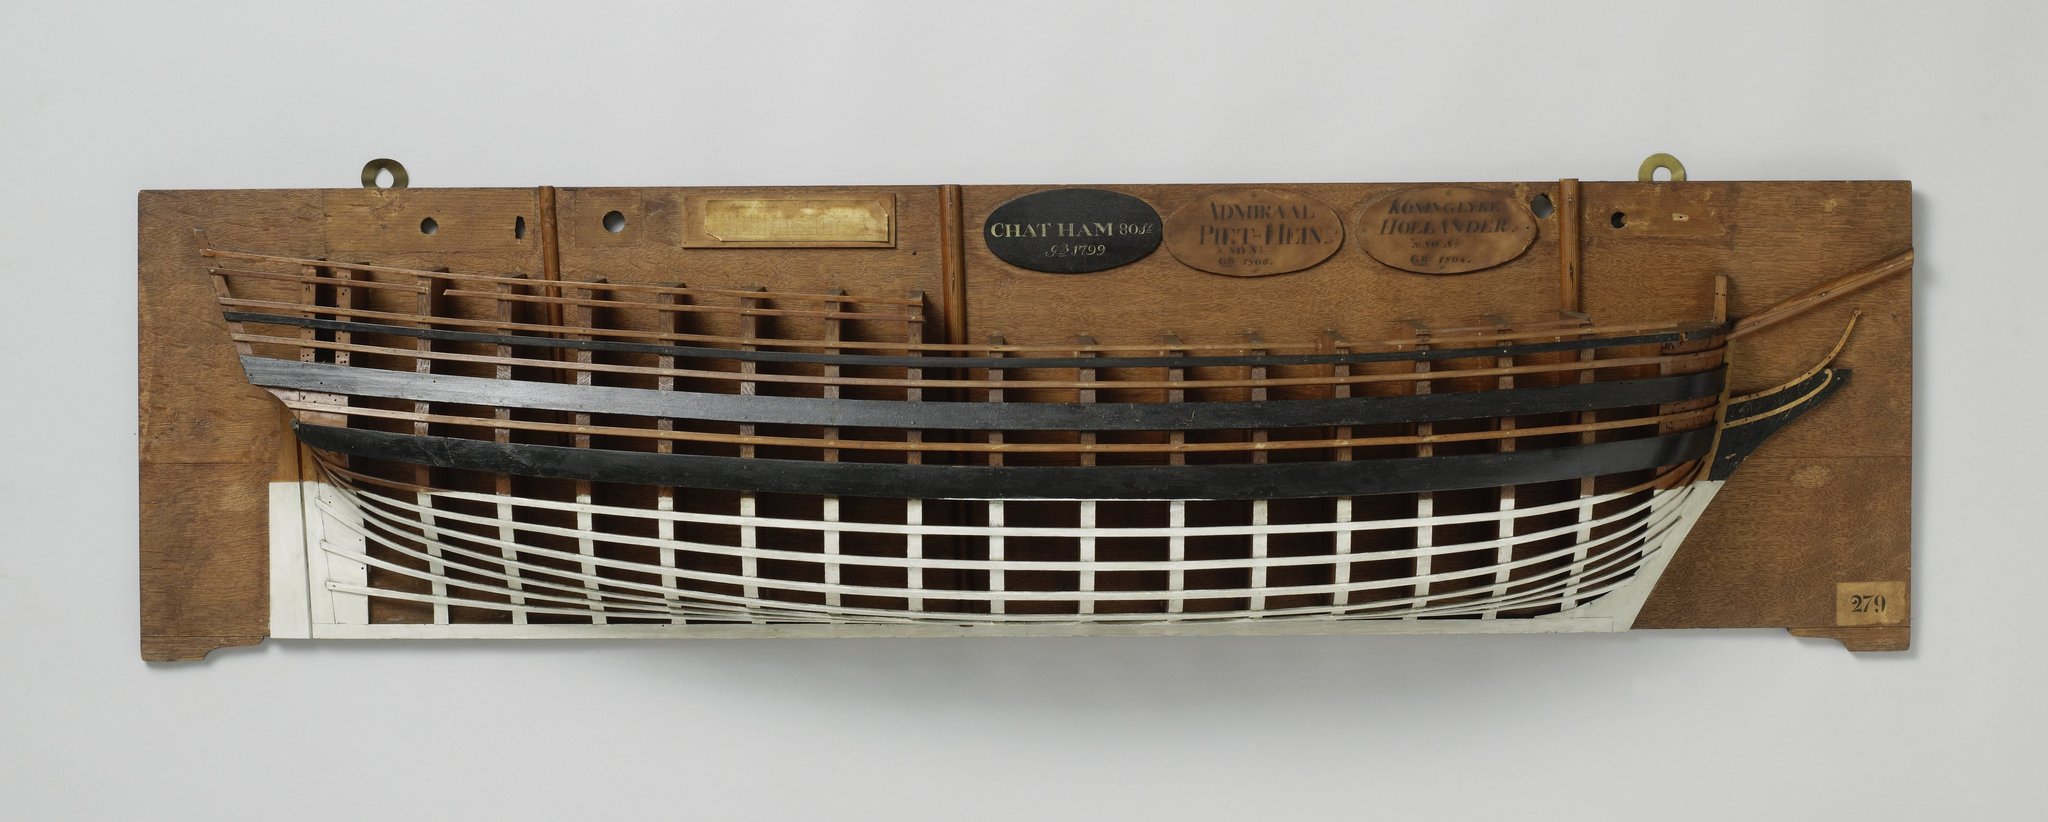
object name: half model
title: Half Model of a 74-Gun Ship of the Line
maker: Anonymous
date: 1806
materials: wood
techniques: polychromy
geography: netherlands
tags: admiraal piet hein (schip)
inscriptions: inscription, top, from left to right, on three oval paper labels (one painted black): ‘CHATHAM 80 St / GB 1799 // ADMIRAAL / PIET-HEIN / à 80 St / GB: 1806. // KONINGLYKE / HOLLANDER. / à 80 St / GB: 1804.’, label, bottom right: ‘279’ former inventory label, scale, top left: paper scale in Amsterdam feet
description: De opschriften zijn onbetrouwbaar. Volgens Obreen werd maar één schip volgens dit model gebouwd, de Admiraal Piet Hein van 195 voet, door P. Glavimans Jz. in Rotterdam in 1810-1813, gesloopt in 1819. Er is echter wel een 74-er Admiraal Piet Hein in Rotterdam op stapel gezet in 1806, op de helling reeds vervuurd en gesloopt in 1811.